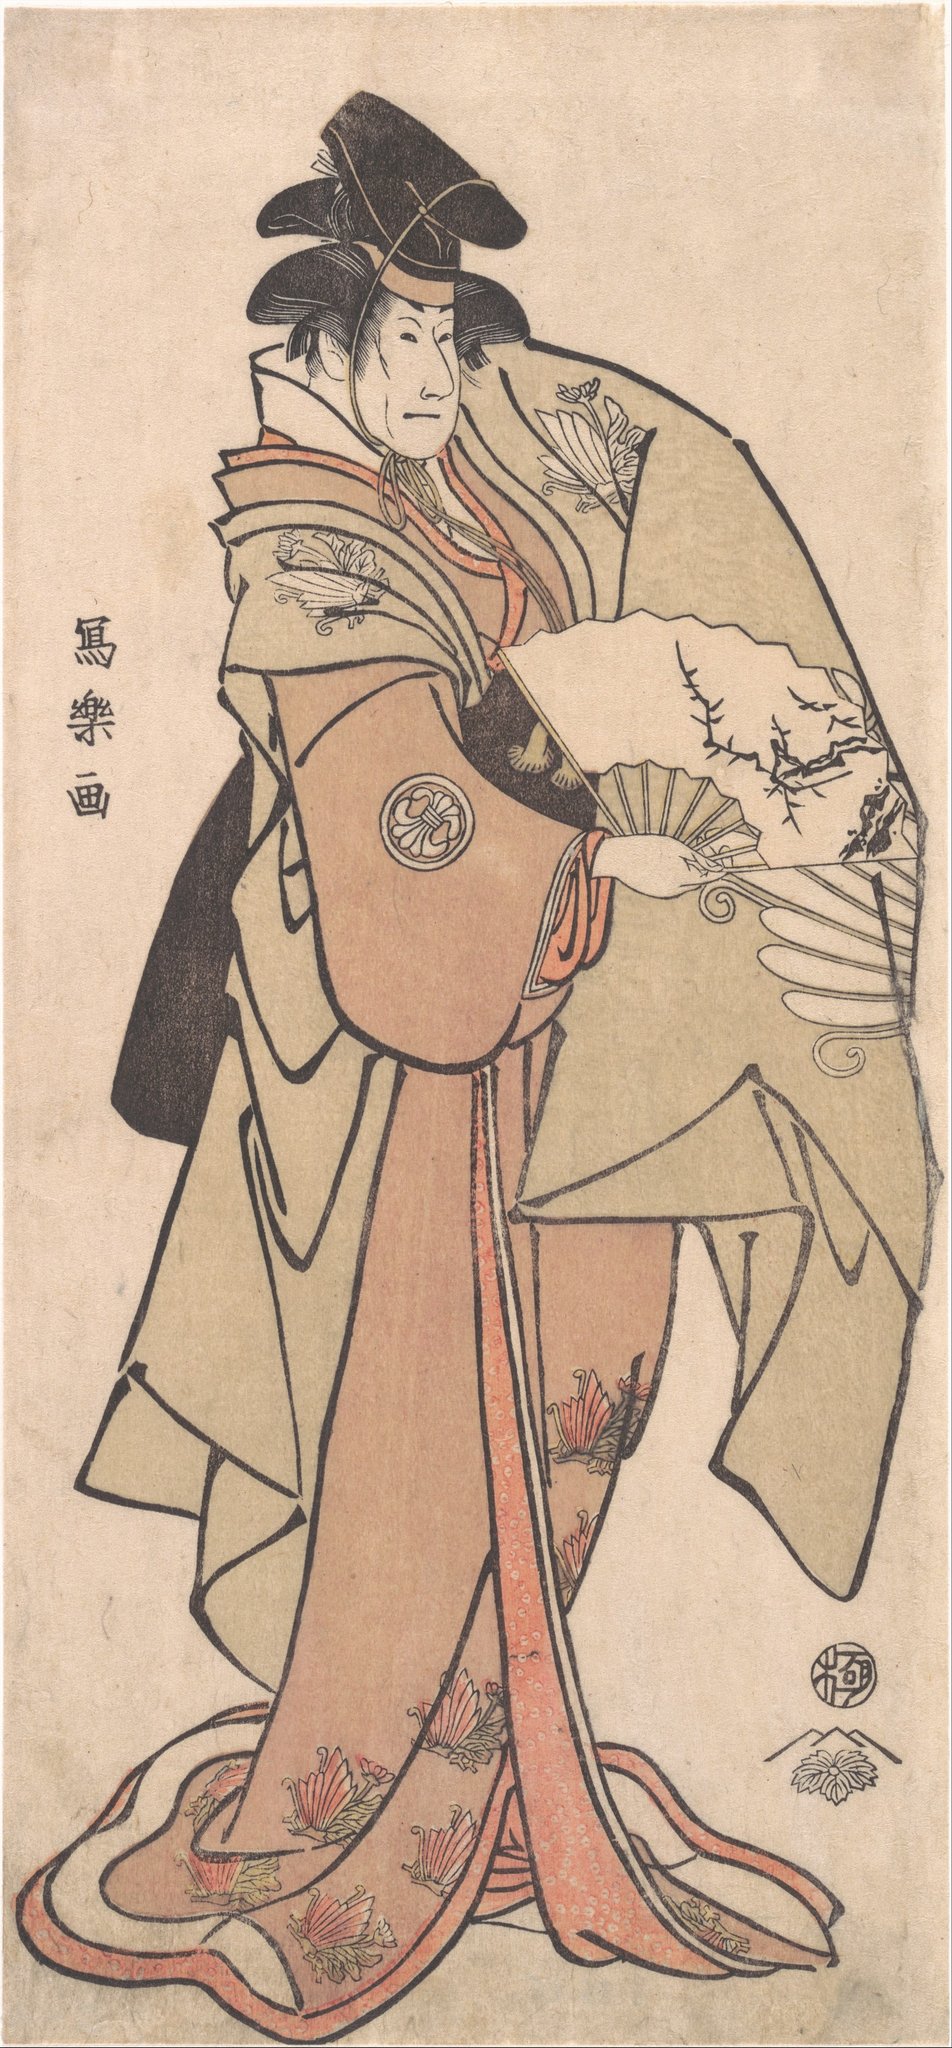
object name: print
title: Segawa Kikunojo III in an Unidentified Role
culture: japanese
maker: tōshūsai sharaku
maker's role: artist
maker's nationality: japanese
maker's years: 1794-1795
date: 1794-1795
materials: ink, mica, paper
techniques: woodblock print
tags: fans,men,actors